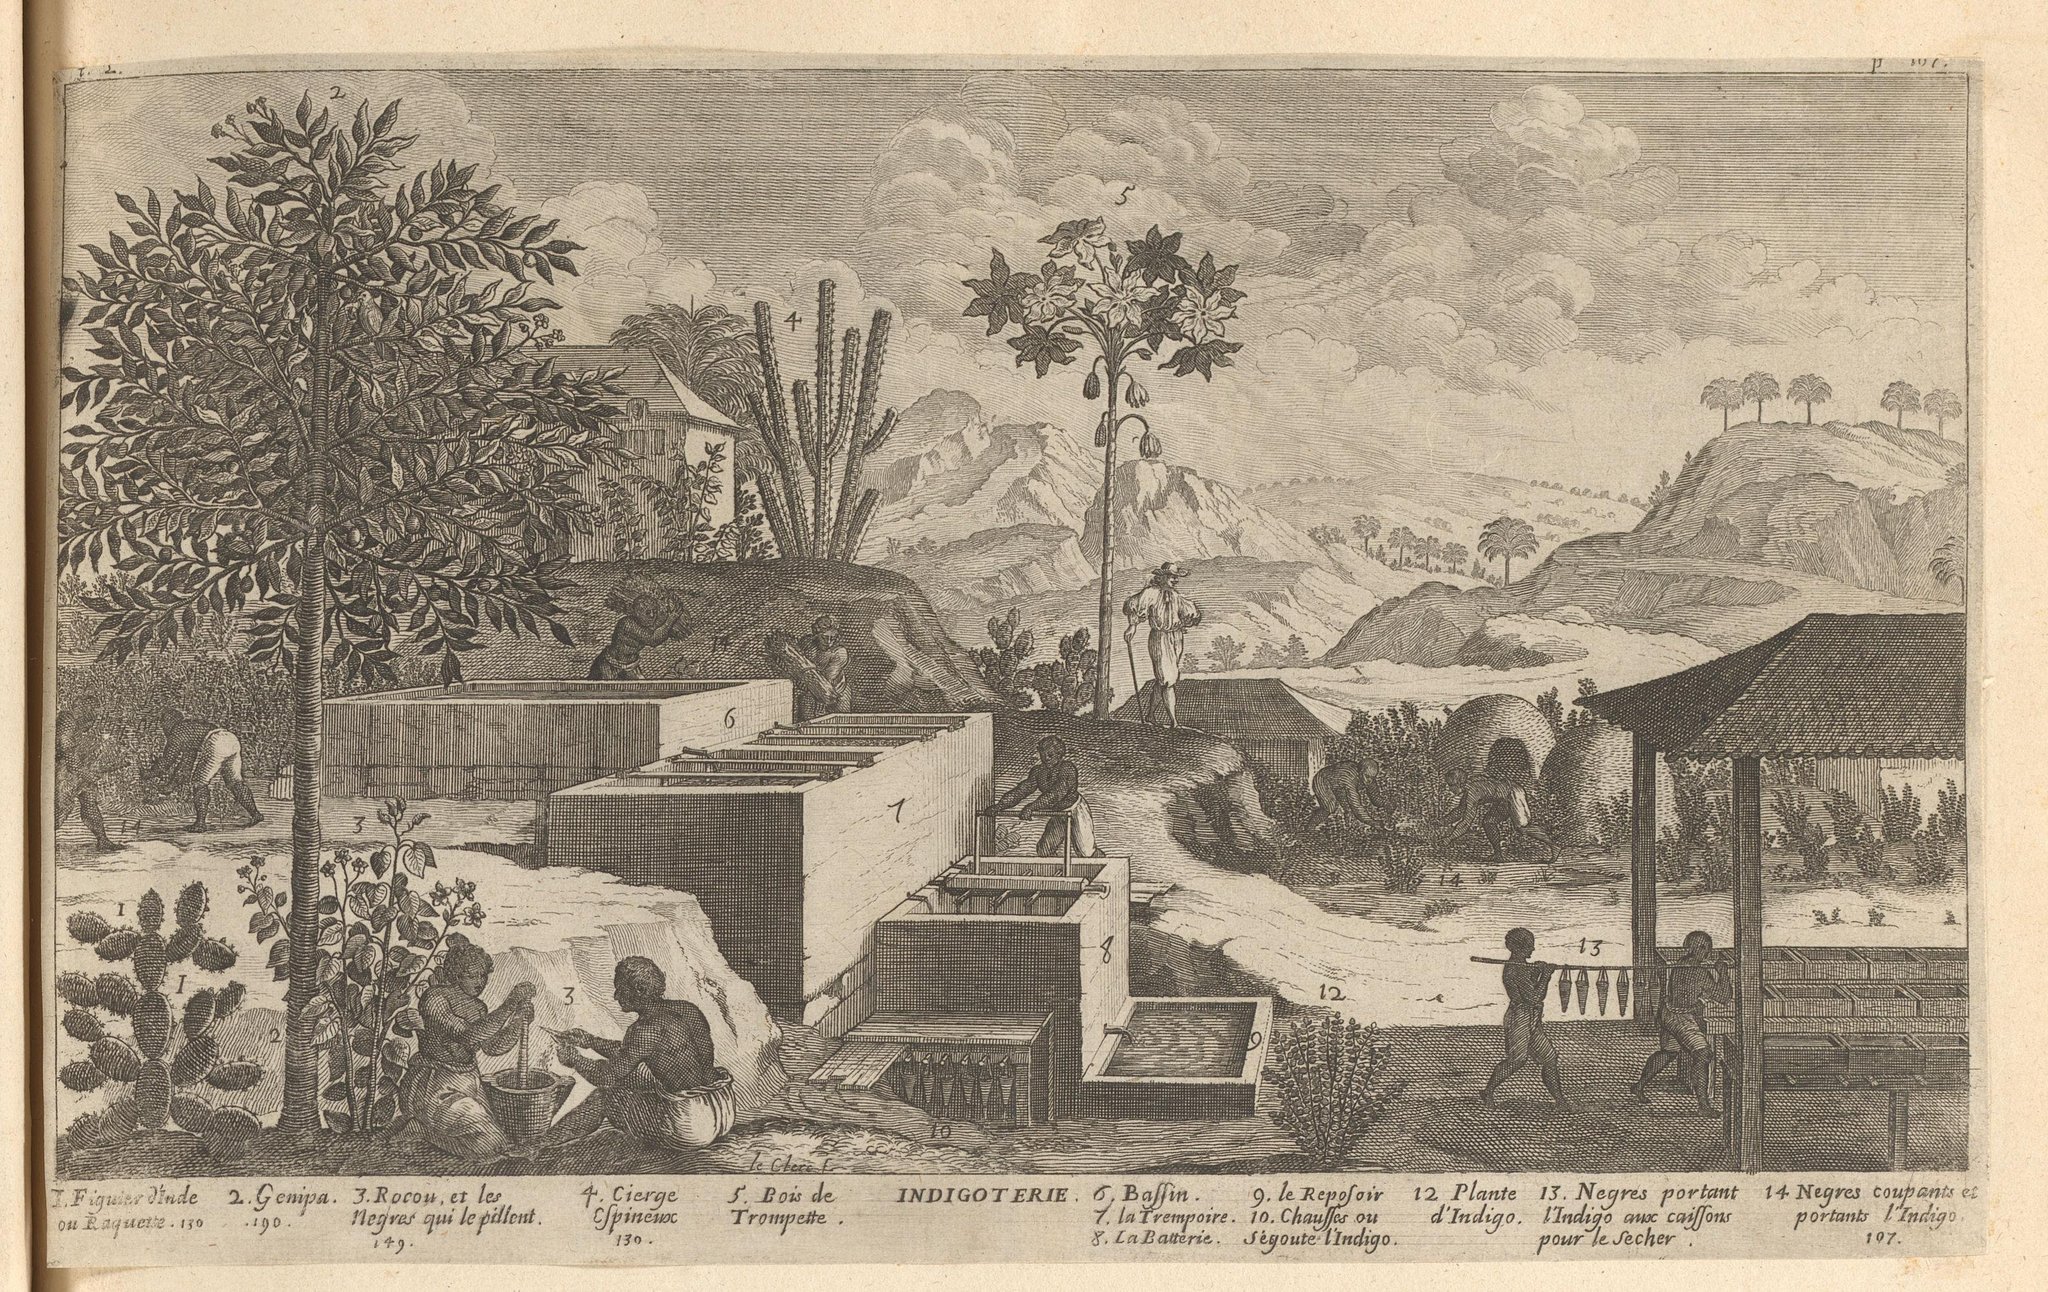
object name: album leaf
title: Indigoterie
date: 1667-1671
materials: paper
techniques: engraving, etching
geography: paris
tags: plantation, colours, pigments, and paints: blue, slavery; serfs and enslaved persons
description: Landschap met een werkplaats waar de kleurstof indigo wordt gefabriceerd door tot slaaf gemaakte mannen en vrouwen, onder toezicht van een Europese, waarschijnlijk Franse toezichthouder. Op de voorgrond zijn verschillende bassins weergegeven waar de bladen van de planten werden geweekt, gefermenteerd en waar een chemisch proces in werking werd gezet waarna een blauw sediment ontstaat dat gevormd en gedroogd werd. Over de gehele prent staan nummers die corresponderen met de Franse tekst in de marge. Rechts onderaan genummerd: 107. Prent maakt deel uit van een album.